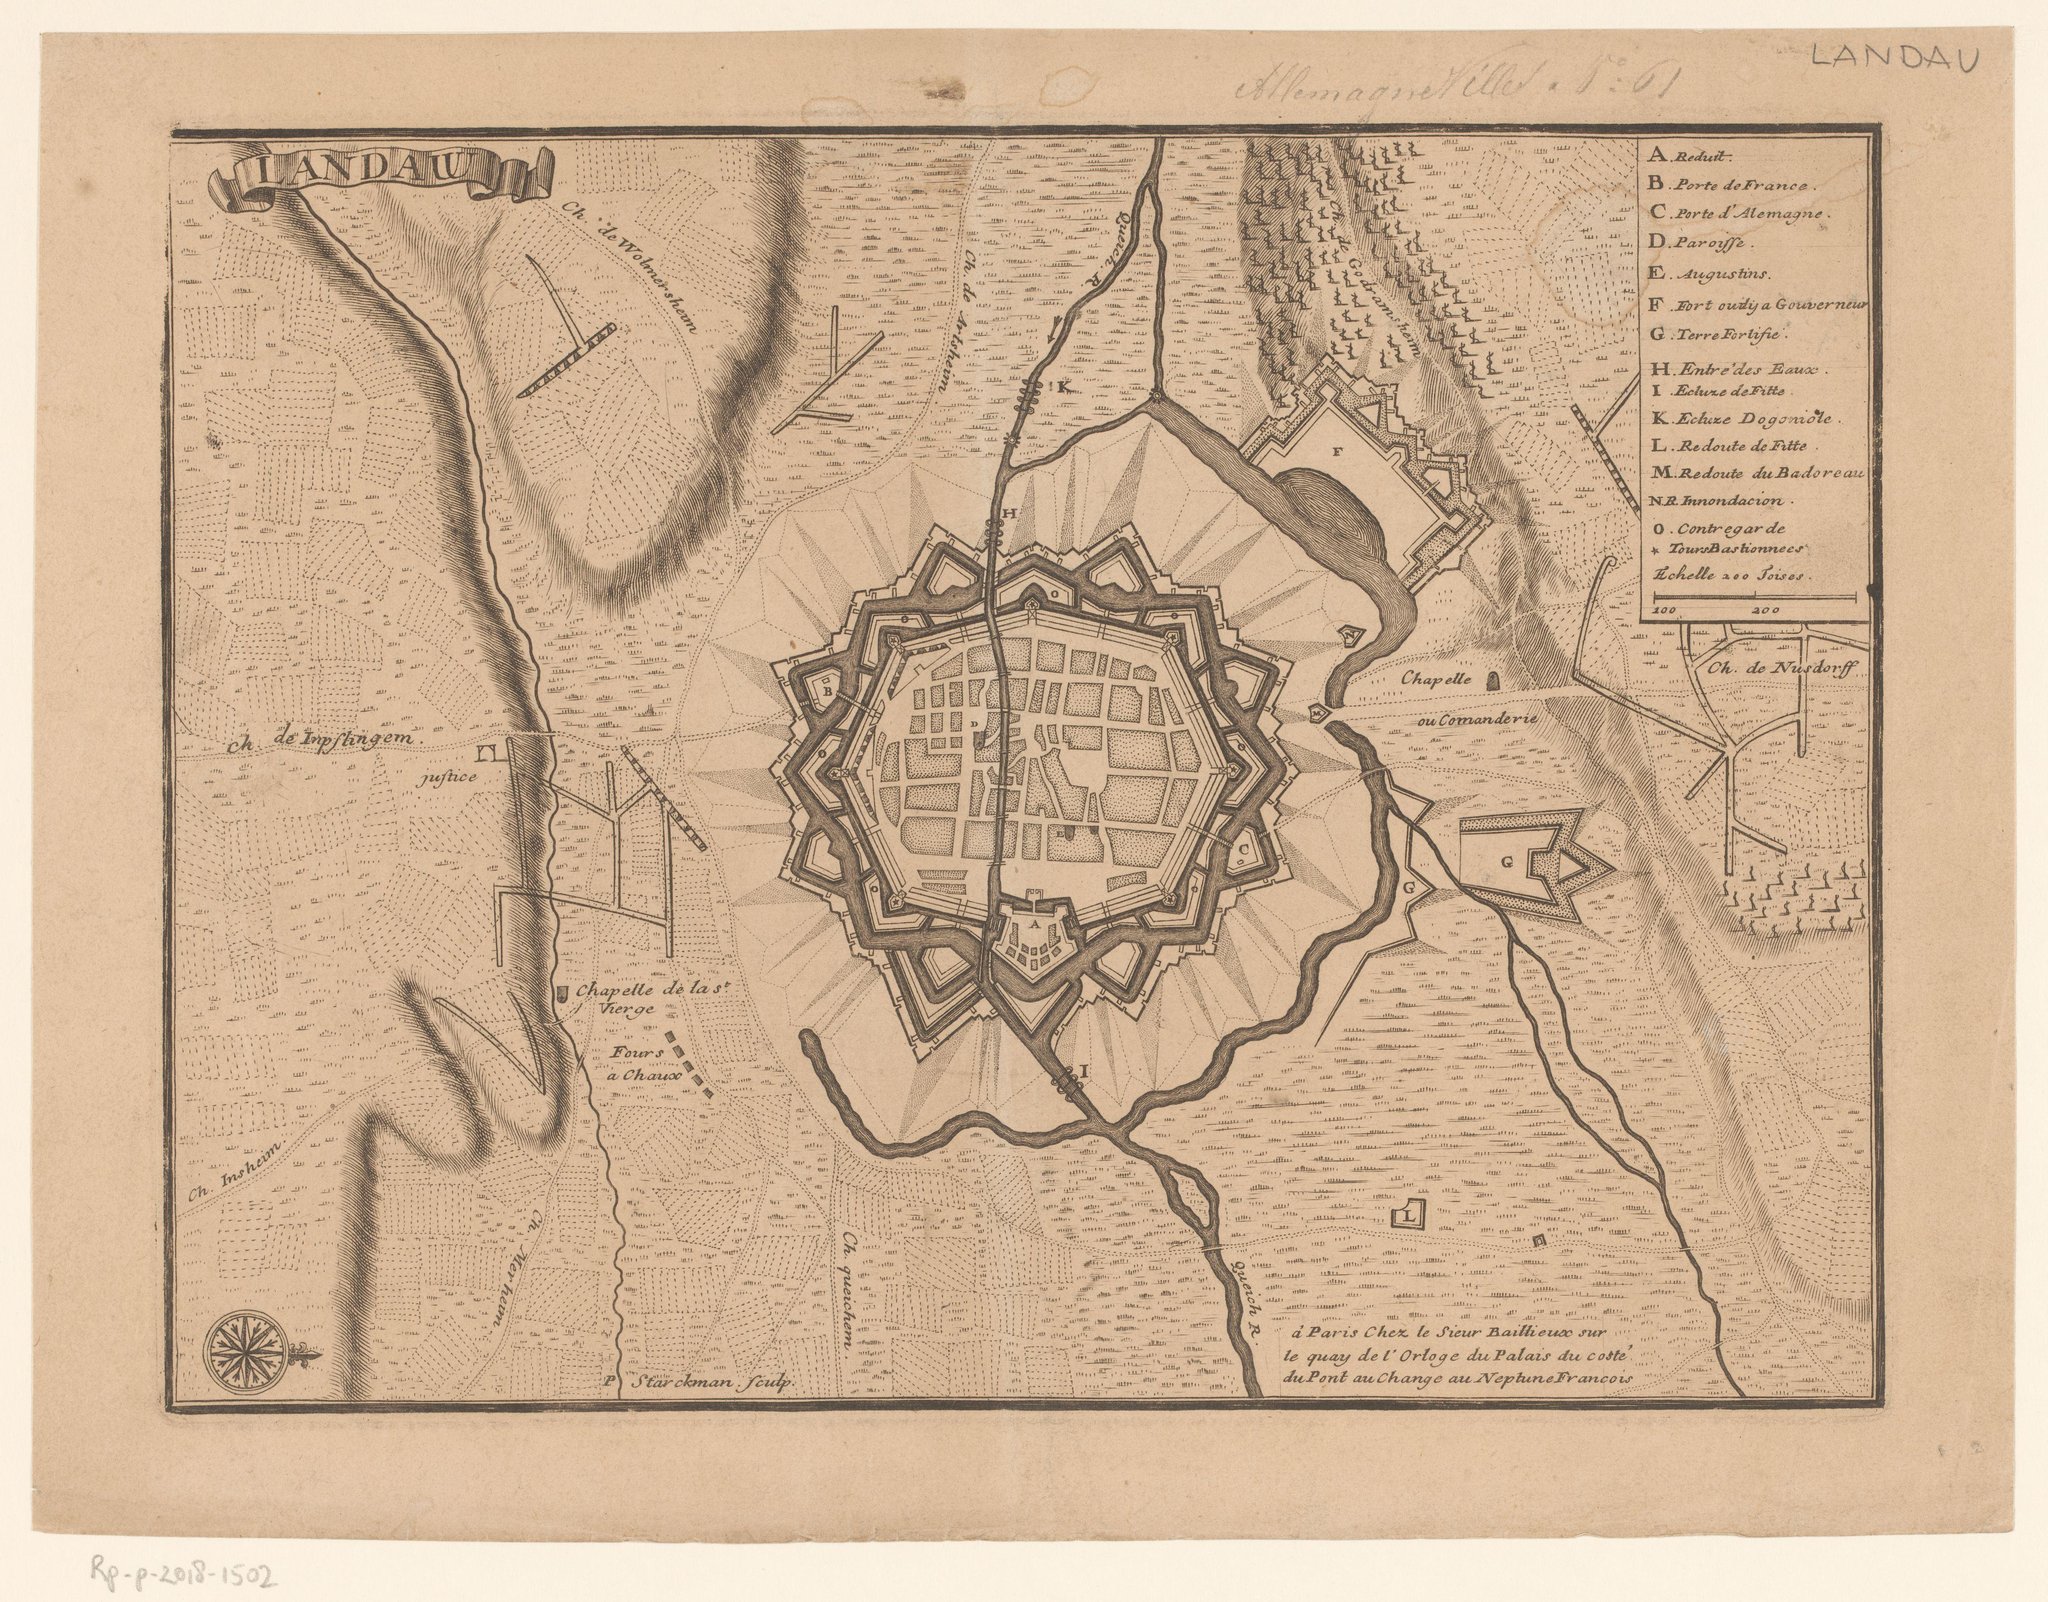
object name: area plan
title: Landaw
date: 1703-1744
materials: paper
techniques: engraving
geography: paris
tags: fortified city, maps of cities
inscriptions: collector's mark: Lugt 2228